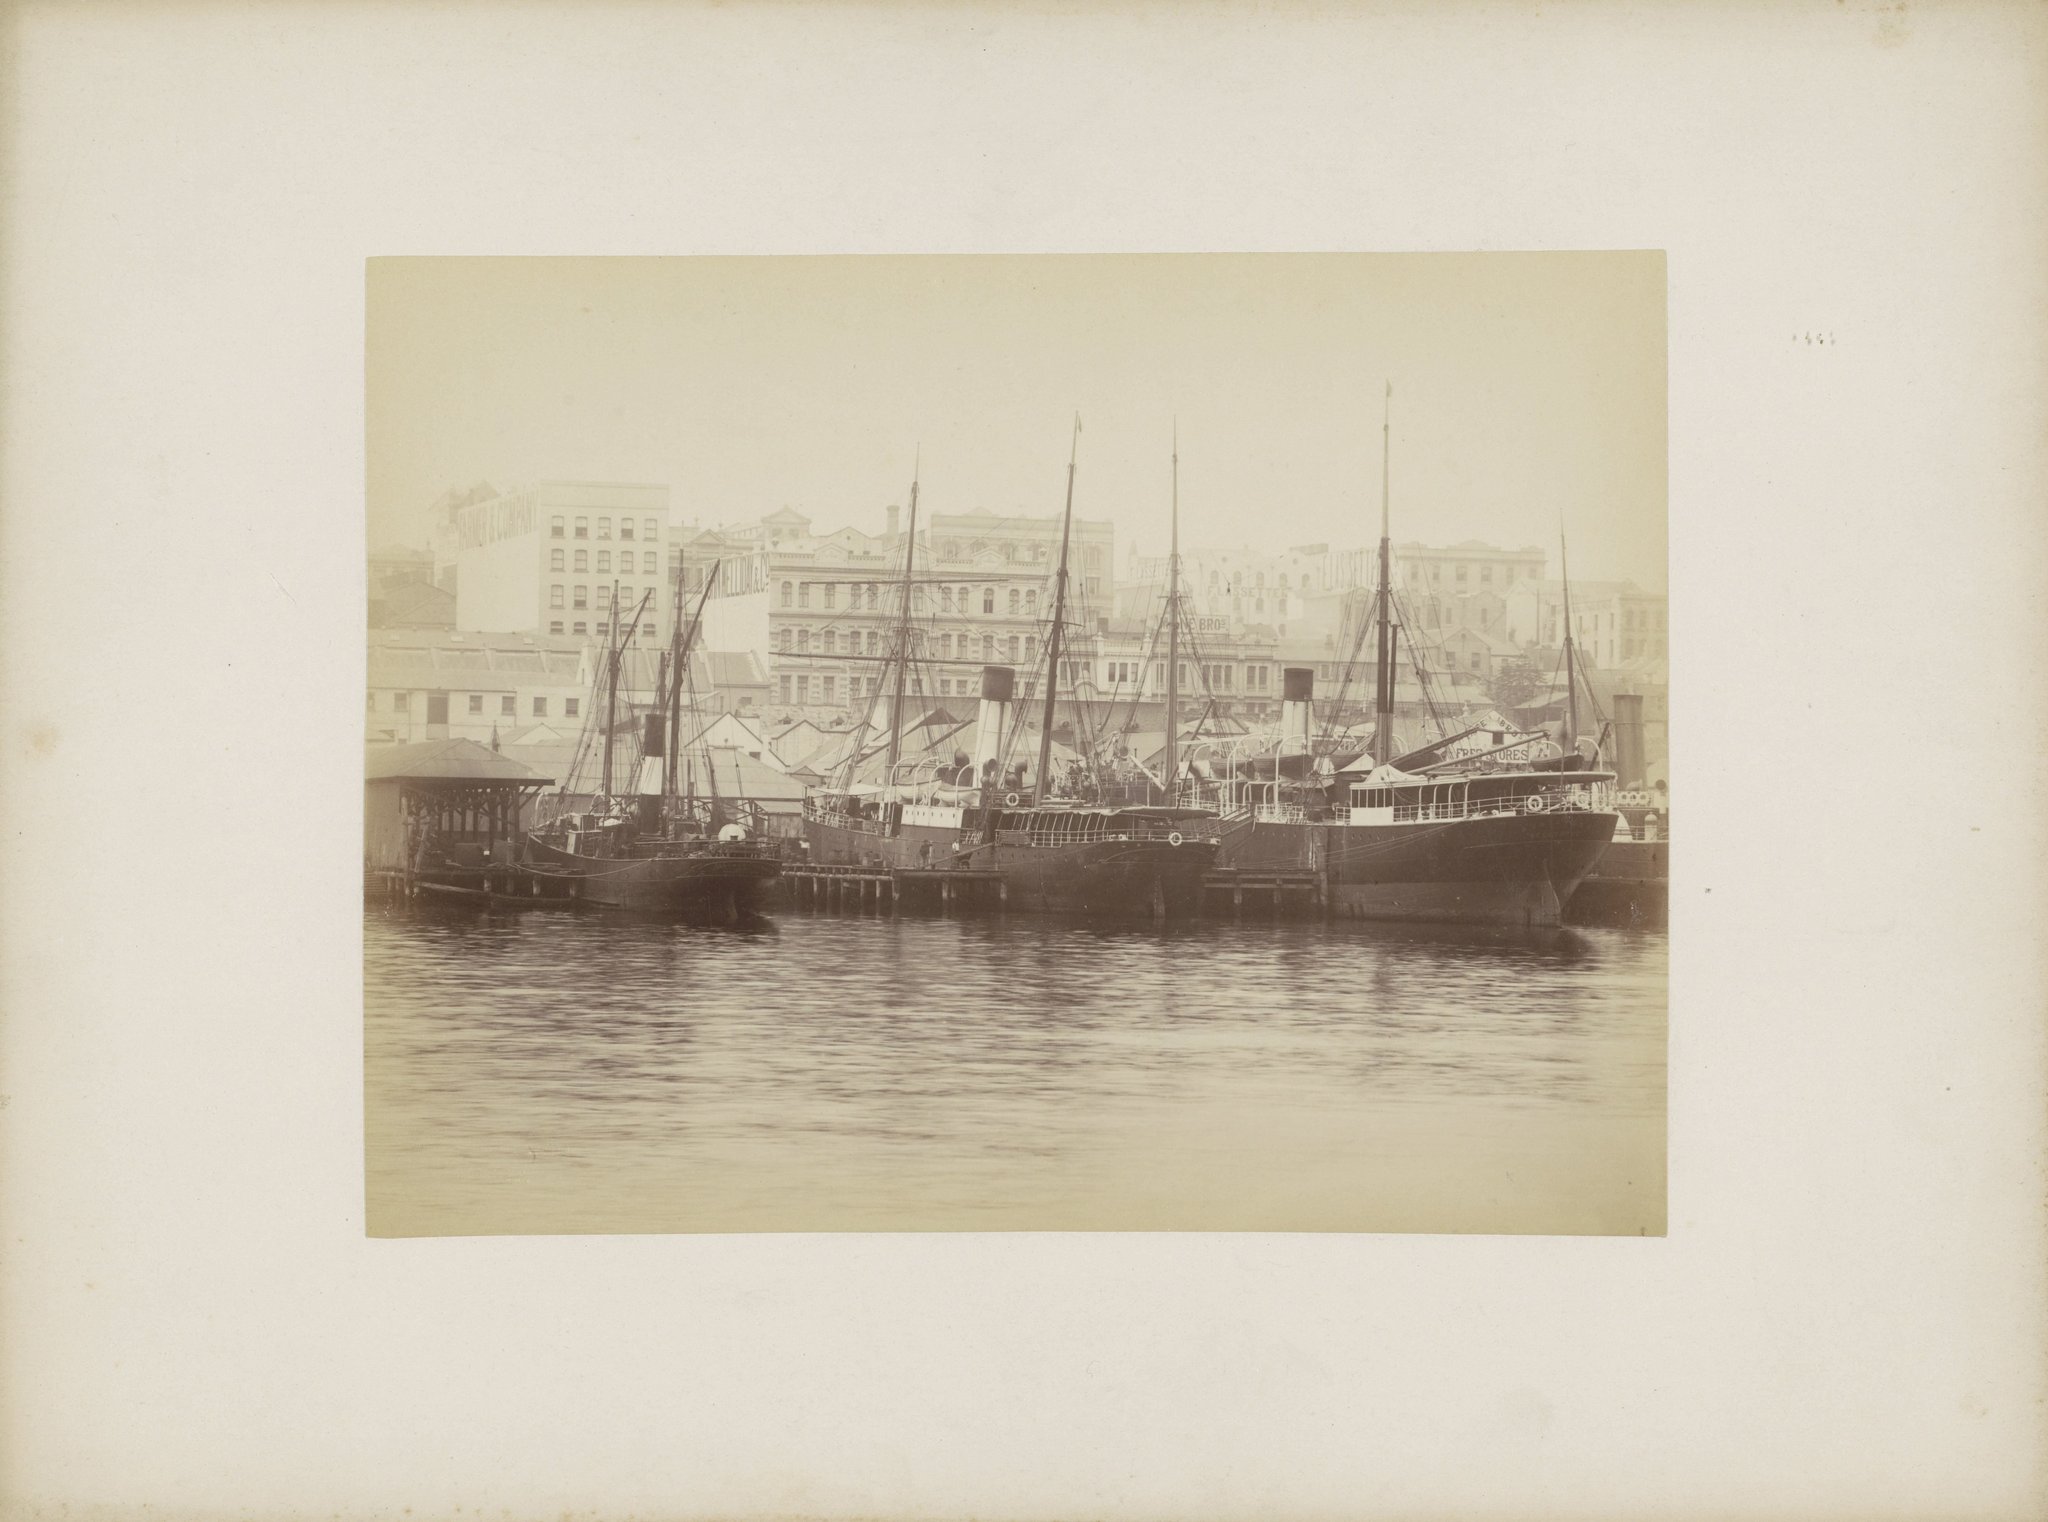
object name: photograph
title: Boten aan de kade in de haven van (vermoedelijk) Sydney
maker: charles bayliss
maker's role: fotograaf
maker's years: 1850-1897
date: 1890-1910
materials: cardboard, paper, photographic support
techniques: albumen print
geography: sydney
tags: sailing-ship, sailing-boat, harbour (+ view ~ vehicle, ship, etc.), steamship, motorship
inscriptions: check stamp: ‘C. Bayliss Photo Sydney’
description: Onderdeel van Reisalbum met foto's van bezienswaardigheden in Sydney.